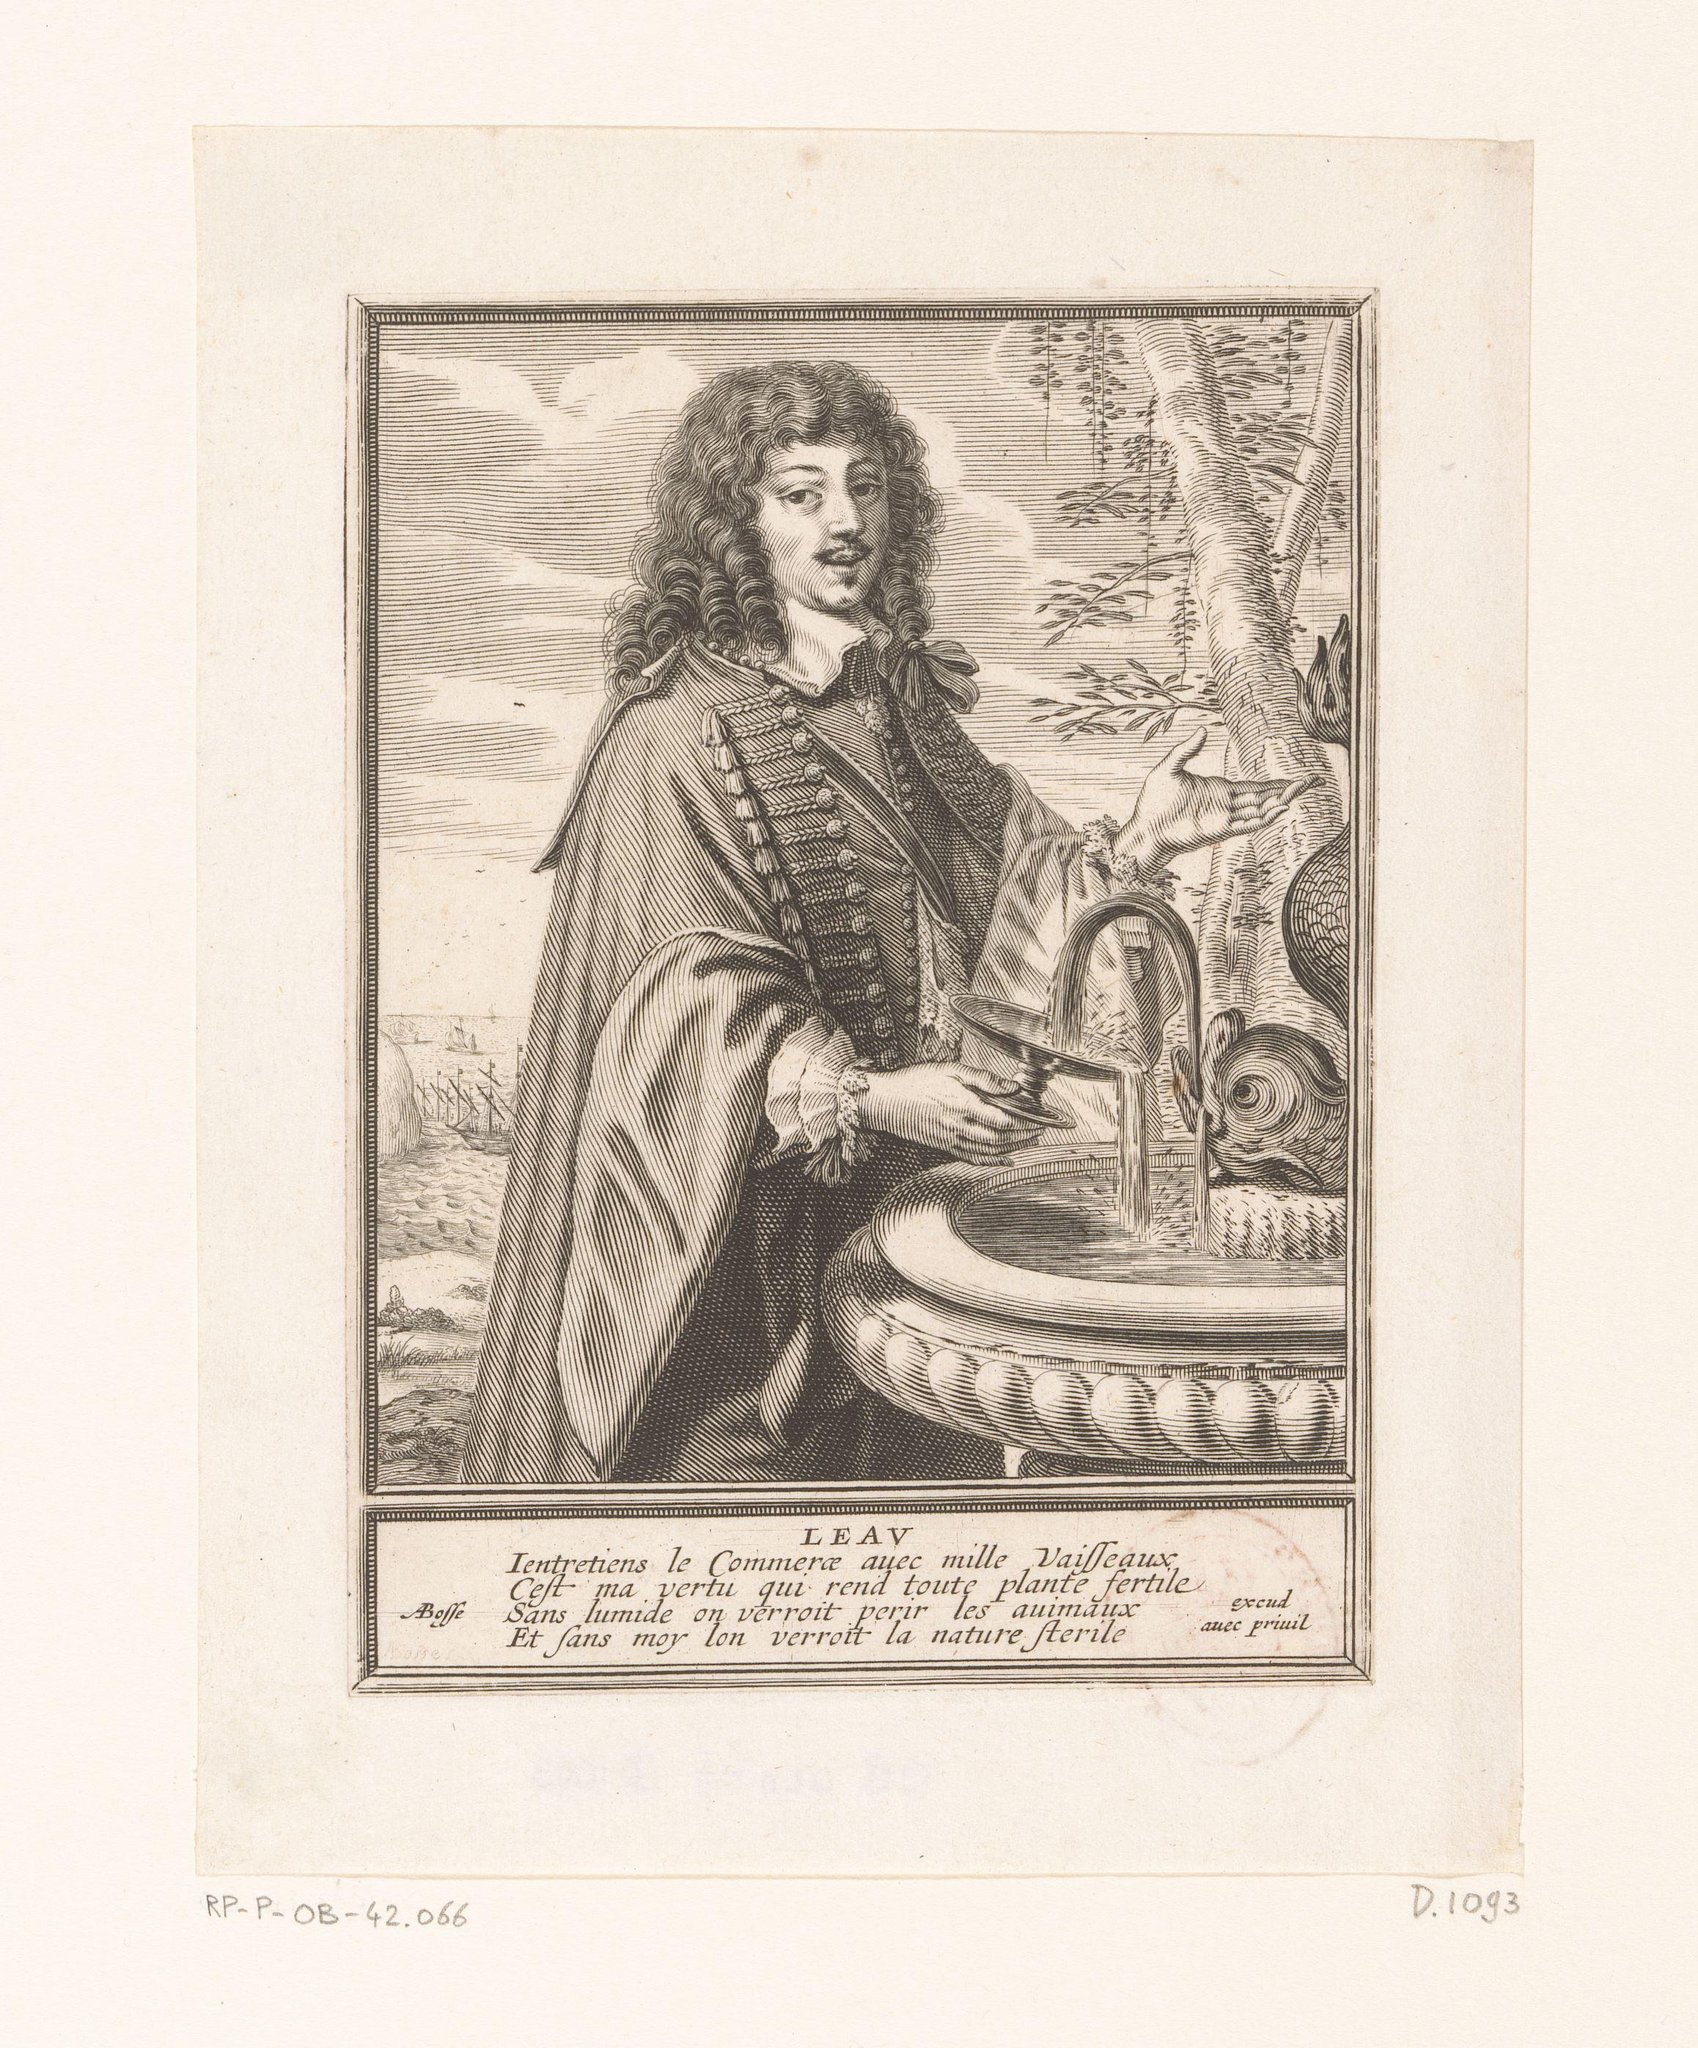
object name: print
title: L'Eau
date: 1612-1676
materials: paper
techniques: engraving, etching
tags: water (one of the four elements), garden fountain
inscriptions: collector's mark: Lugt 240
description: Maakt deel uit van een serie van vier prenten met de vier elementen in menselijke gedaanten.